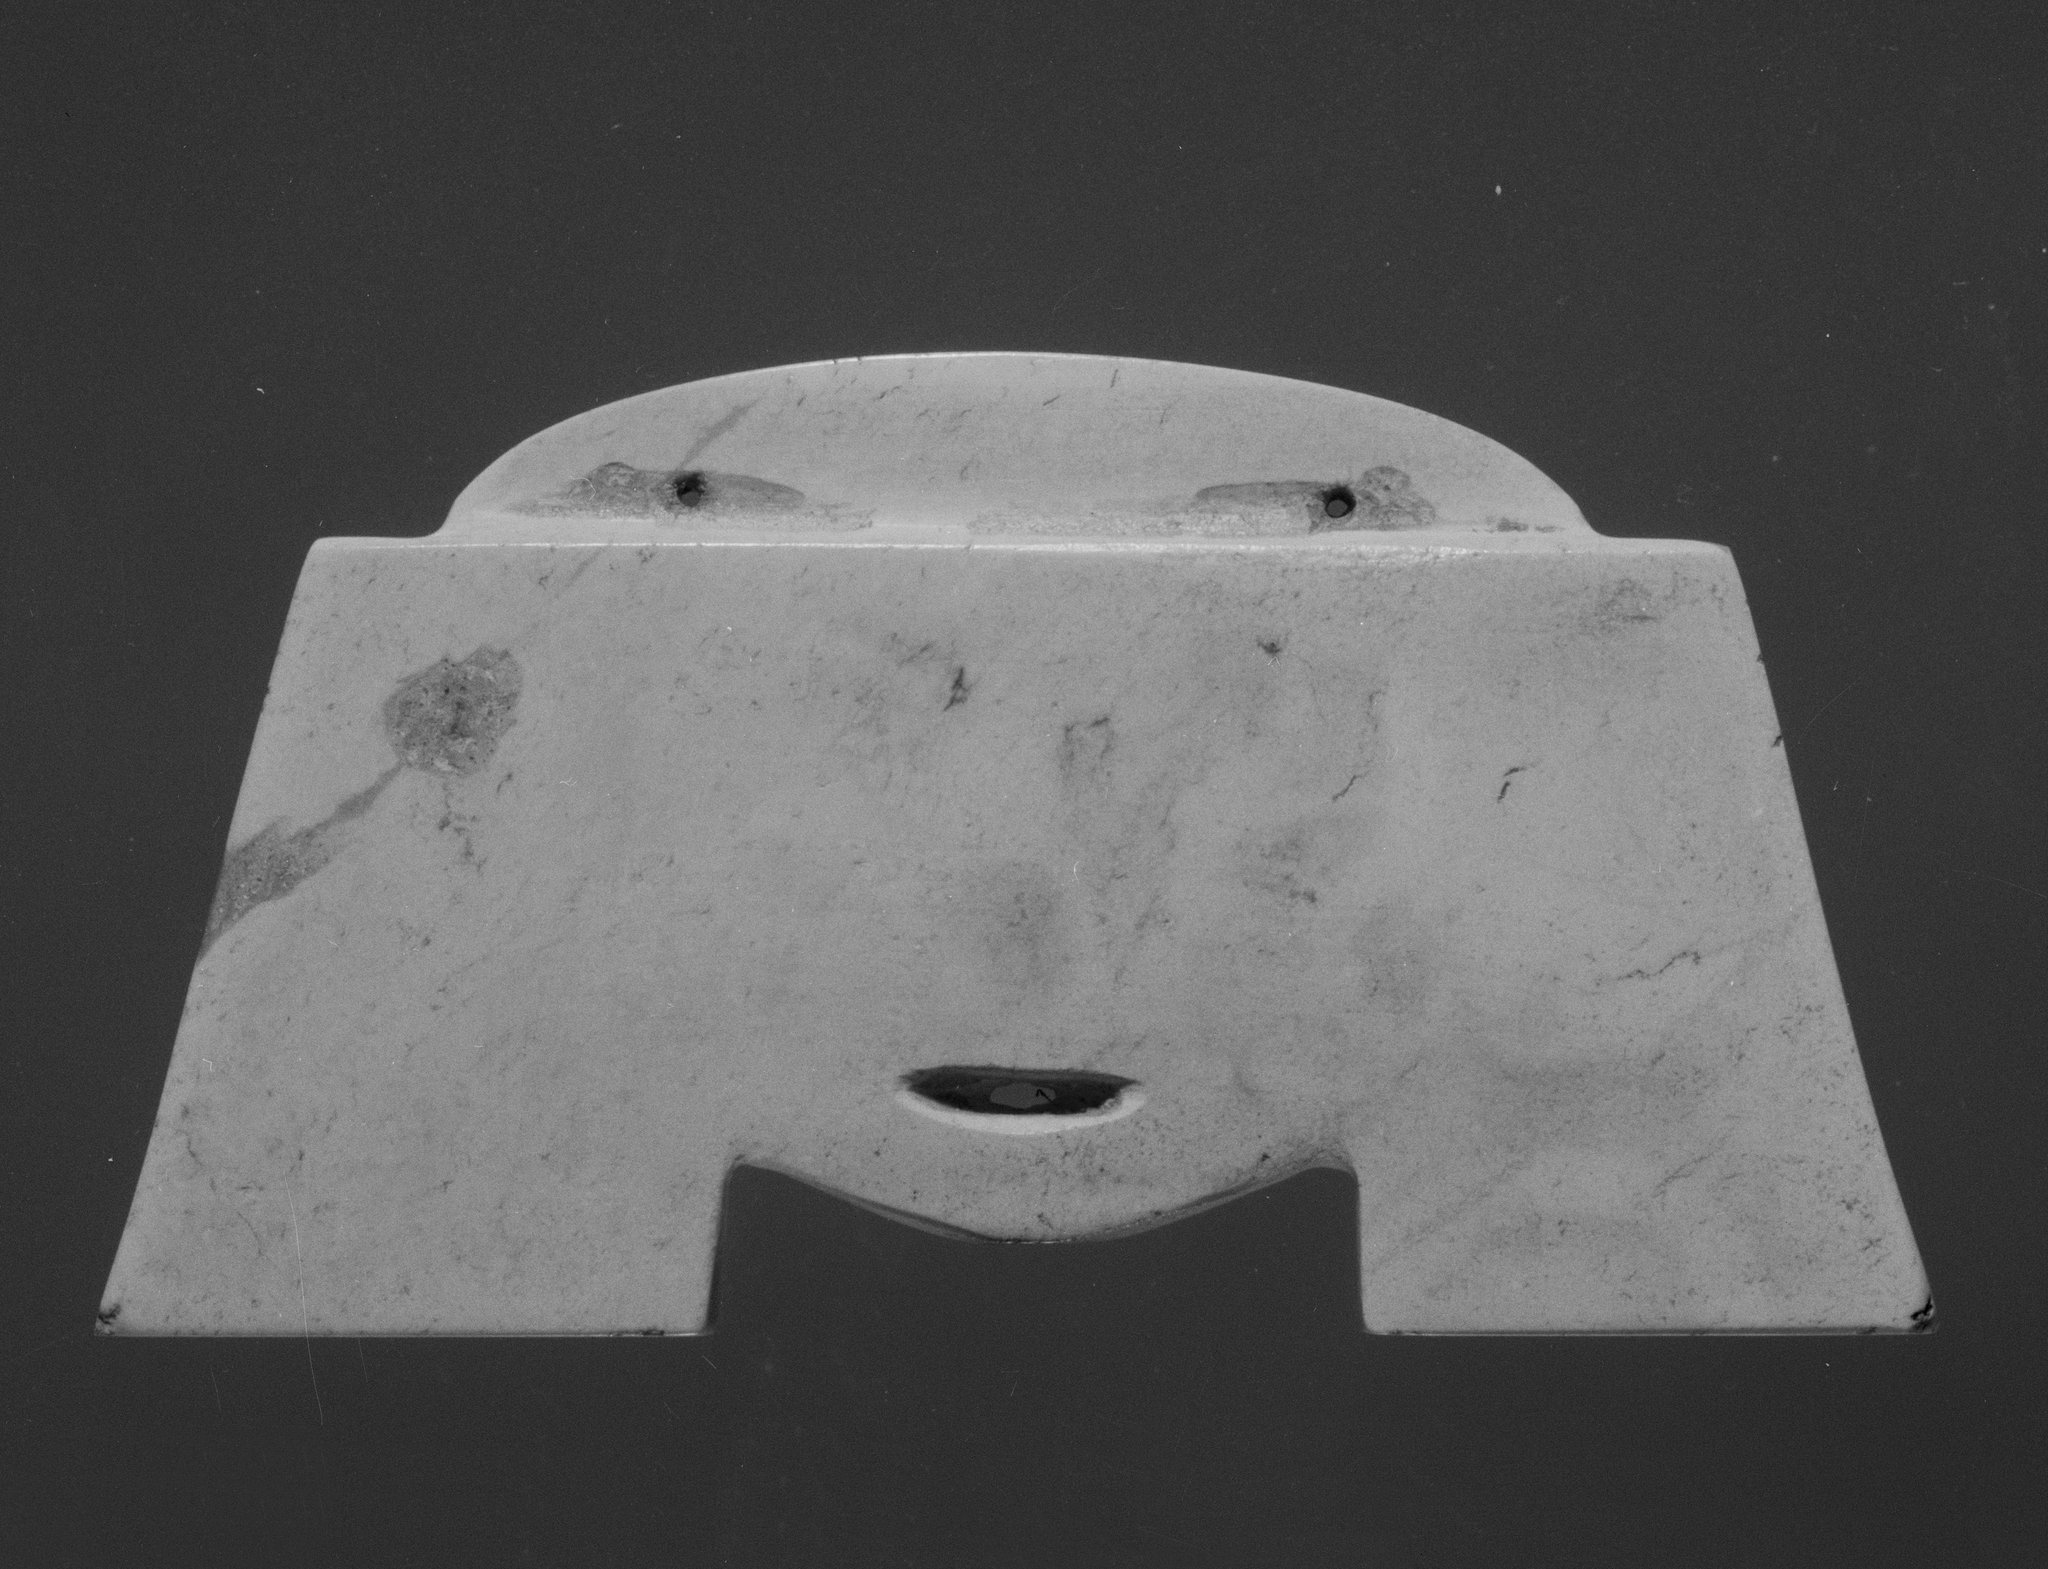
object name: pendant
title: Ivory Tone Pendant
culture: chinese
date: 2400-2000 BCE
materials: jade